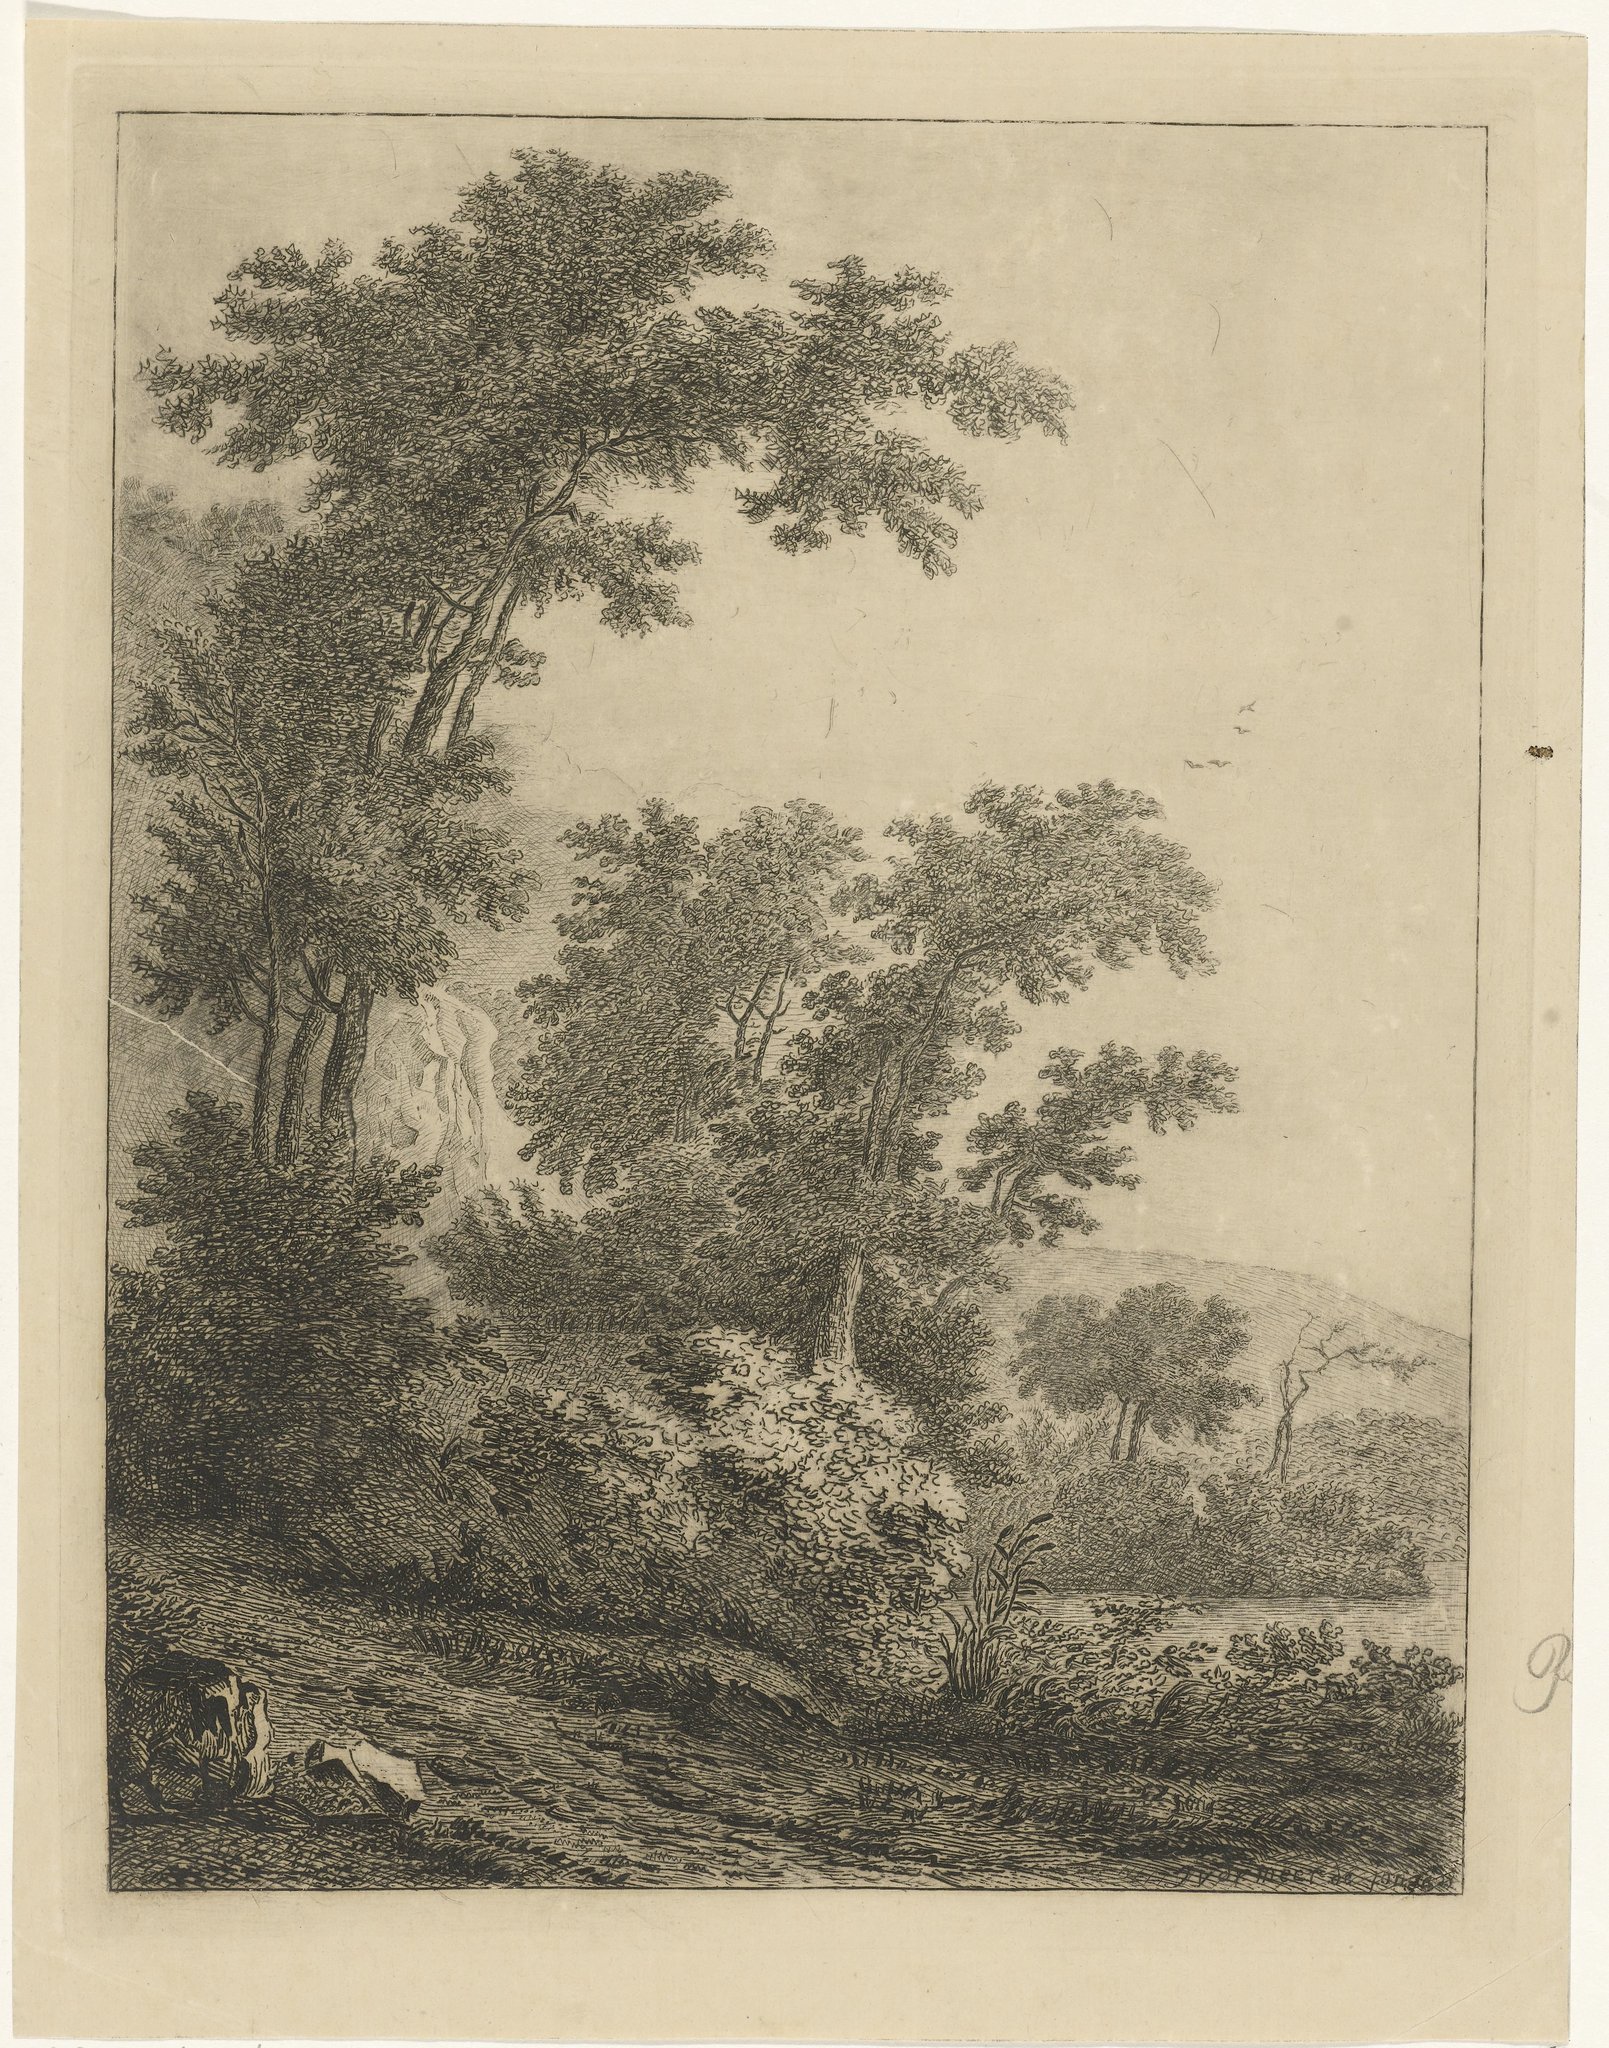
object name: print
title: Landschap met hoge bomen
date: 1796-1856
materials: paper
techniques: engraving, etching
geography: vaassen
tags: trees, landscapes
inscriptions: collector's mark: Lugt 2228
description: Landschap met hoge bomen en links water.